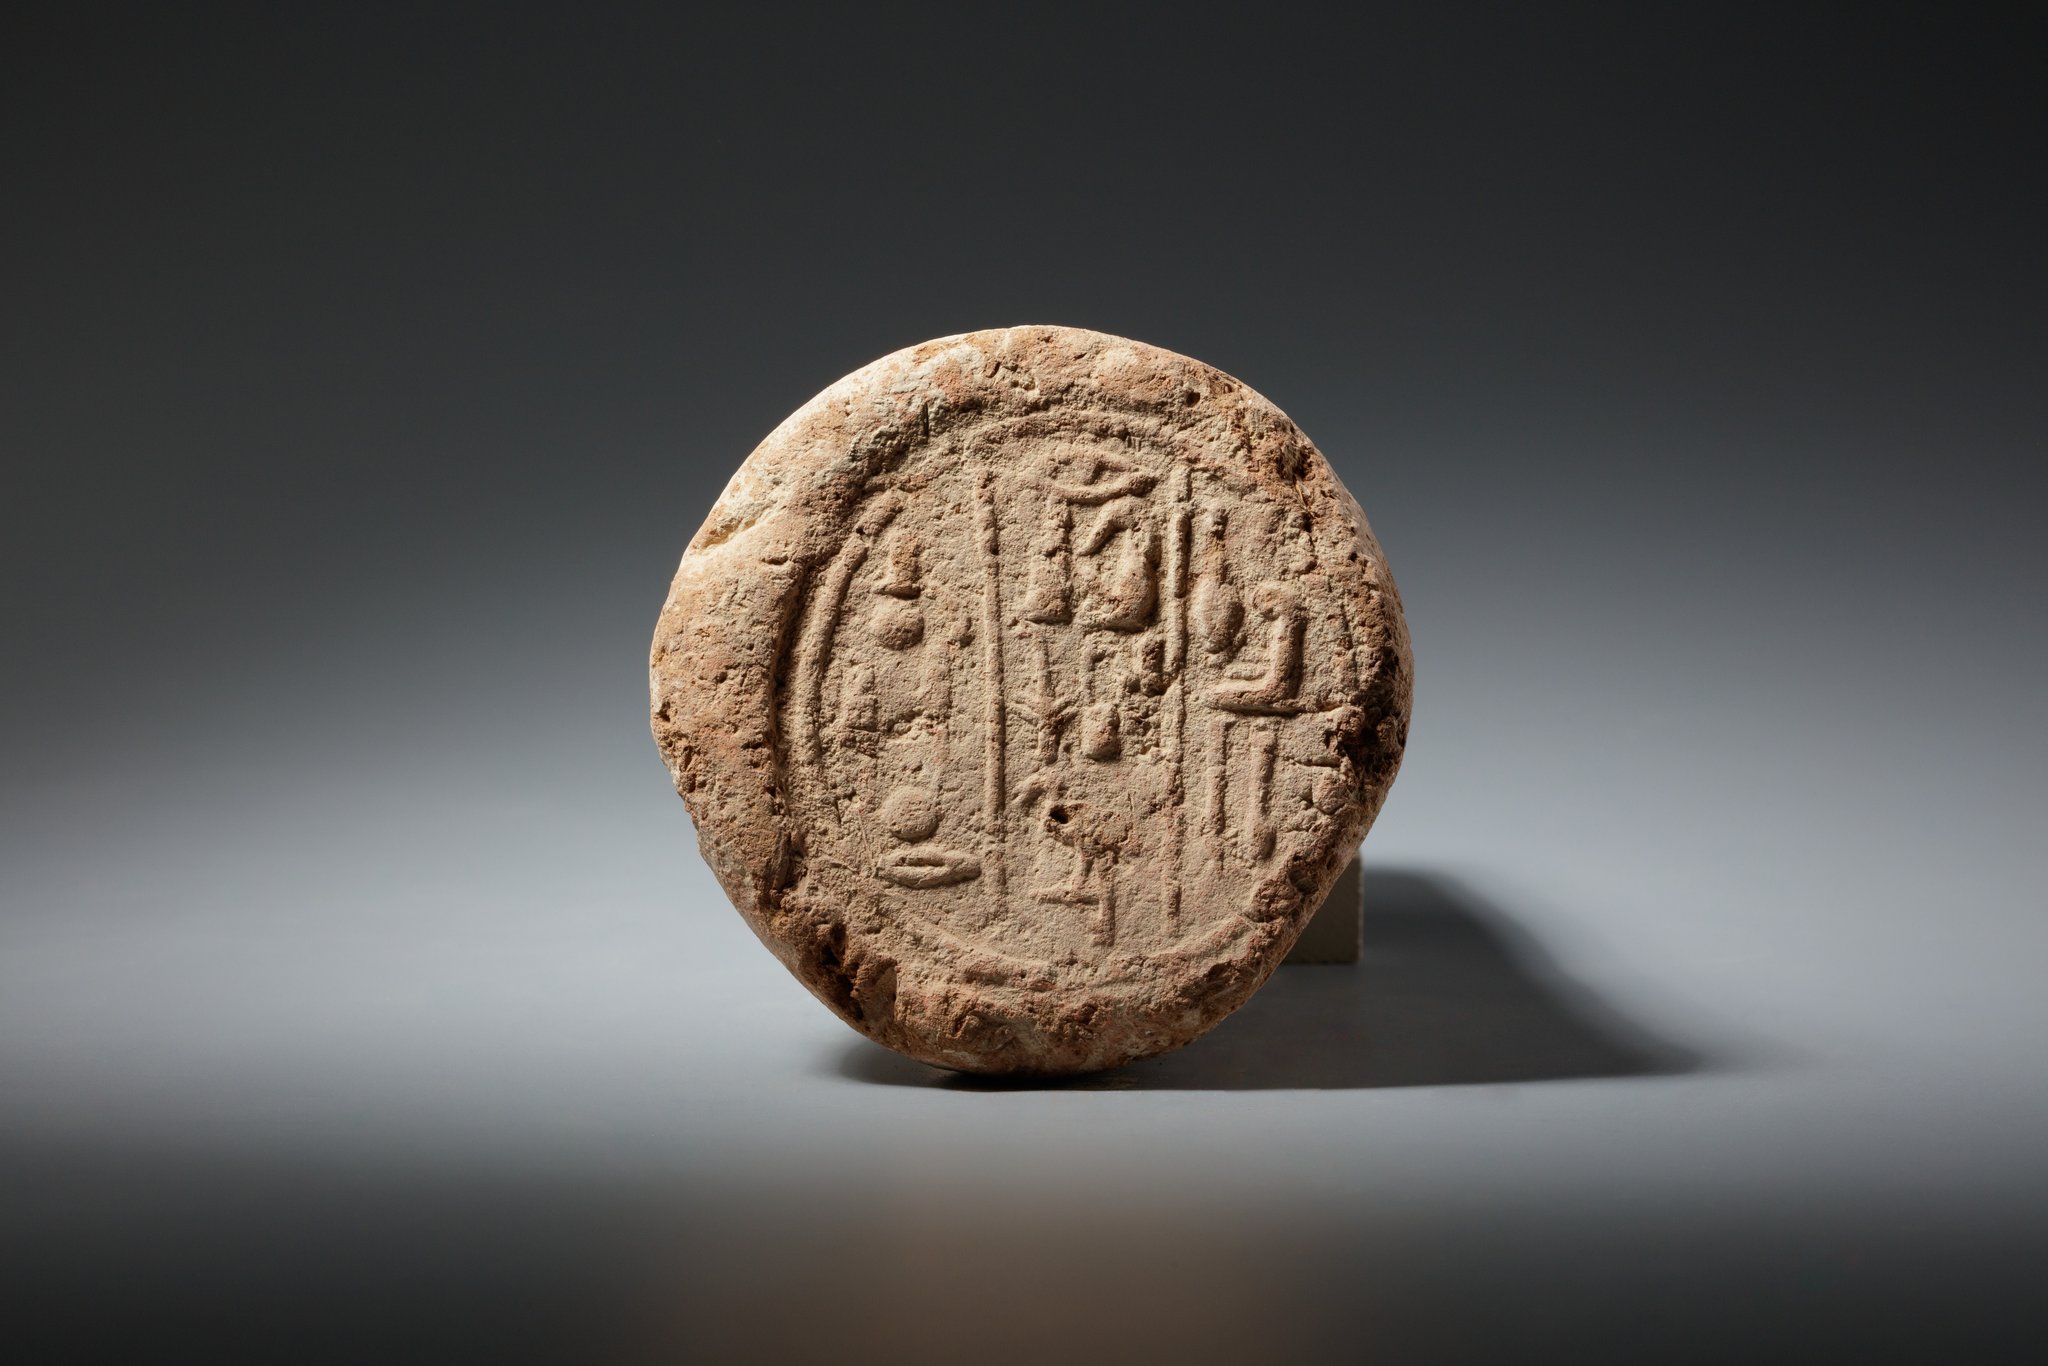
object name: cone, davy 176, djehutynefer, tt 104, royal scribe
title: Funerary Cone the Royal Scribe Djehutynefer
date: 1550-1295 BCE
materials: pottery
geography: egypt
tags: hieroglyphs